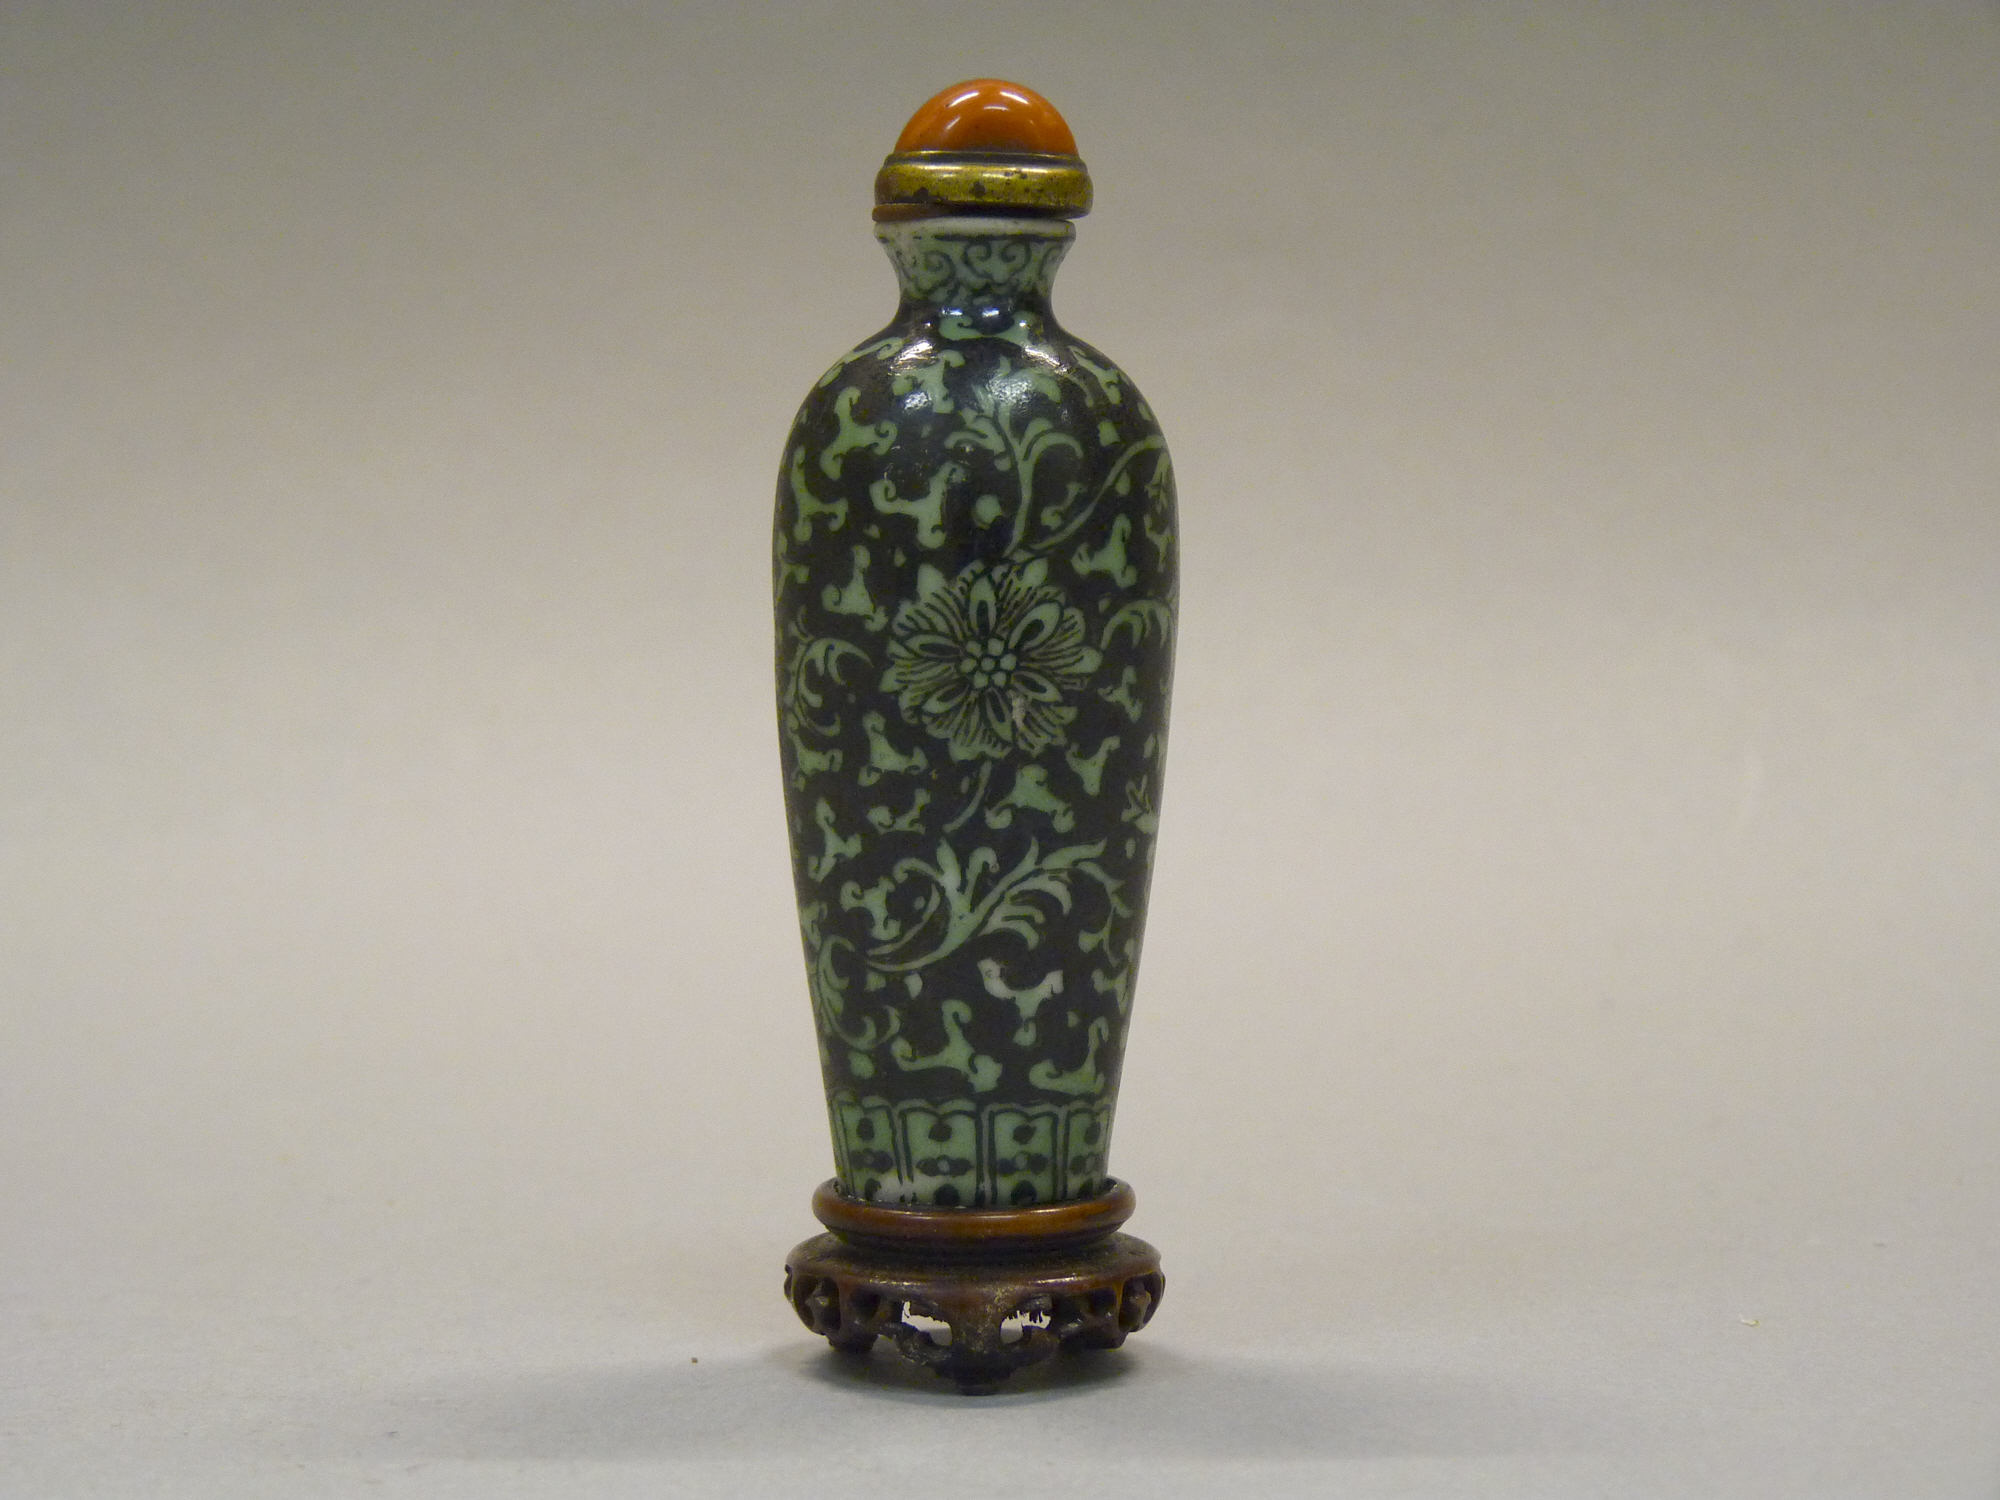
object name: snuff bottle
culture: chinese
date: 1736-1795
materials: coral, porcelain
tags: flowers